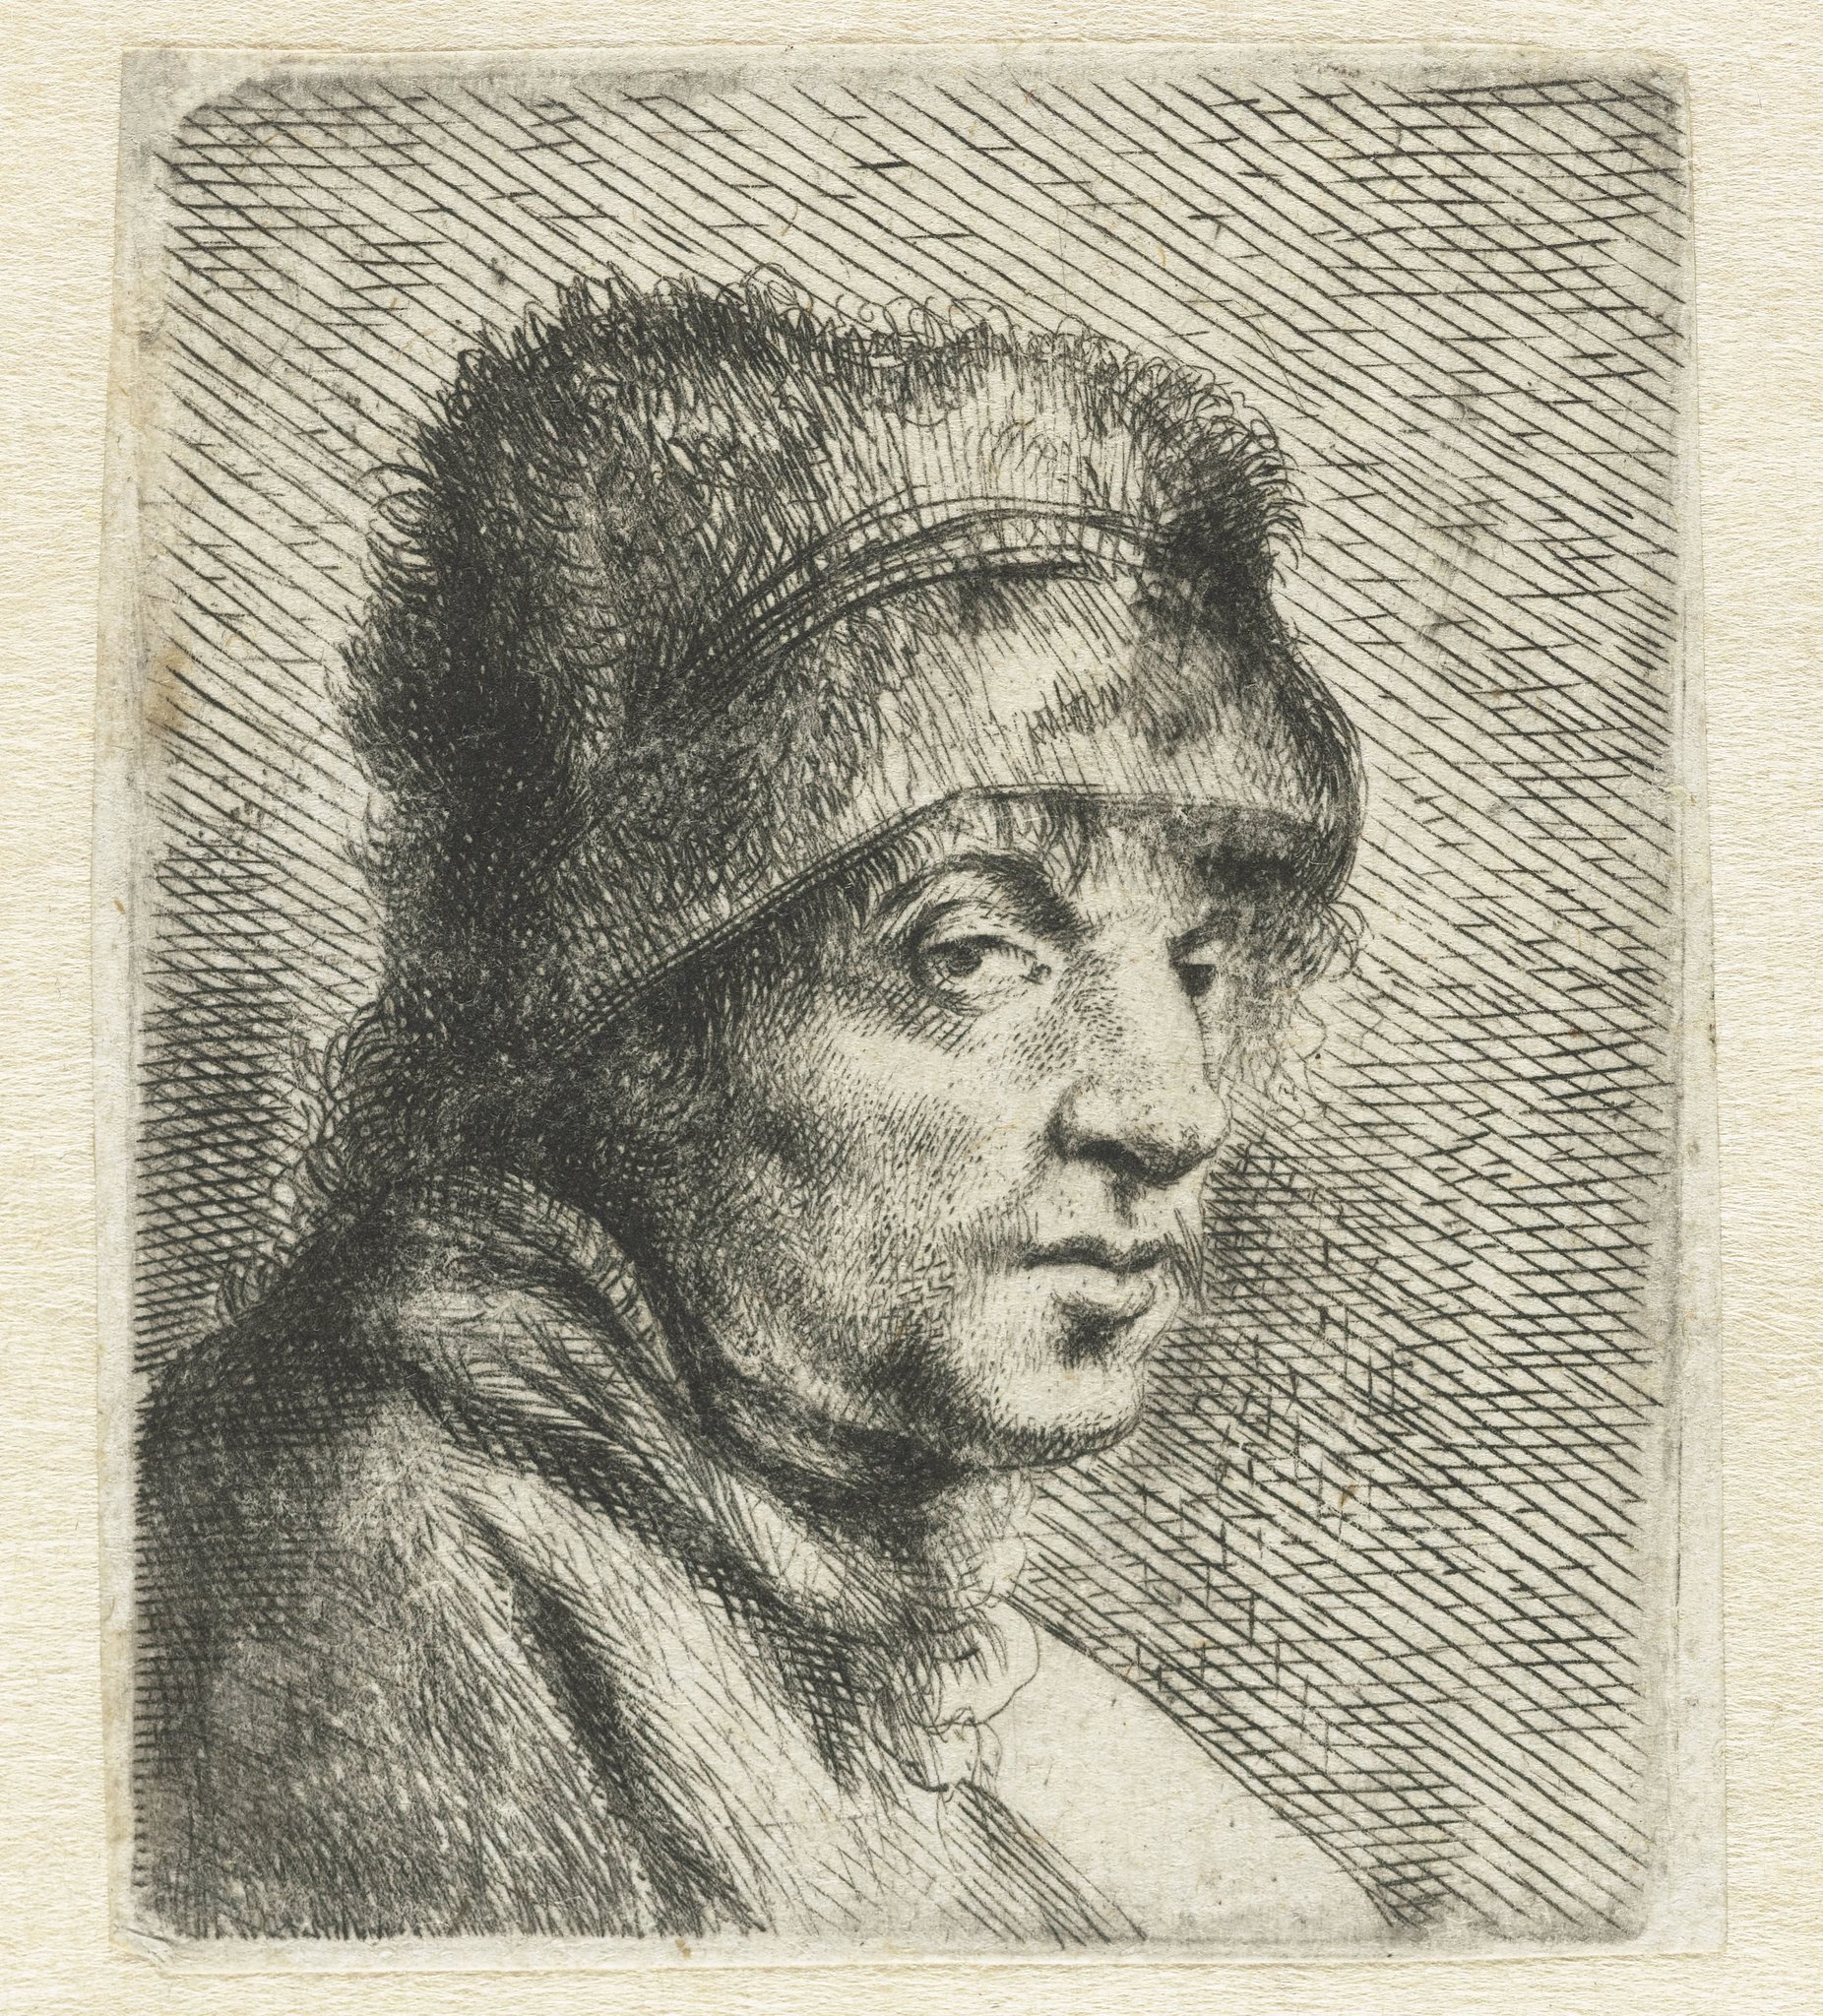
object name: print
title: Hoofd van een man met muts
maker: jan lievens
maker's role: draughtsman, painter, print maker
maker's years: 1607-1674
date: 1625-1674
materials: paper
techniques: engraving, etching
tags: adult man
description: Deze prent maakt deel uit van een serie kleine mannenkoppen waar ook een titelprent van bewaard is gebleven. Het is niet helemaal duidelijk welke mannentronies deze serie compleet maakten.